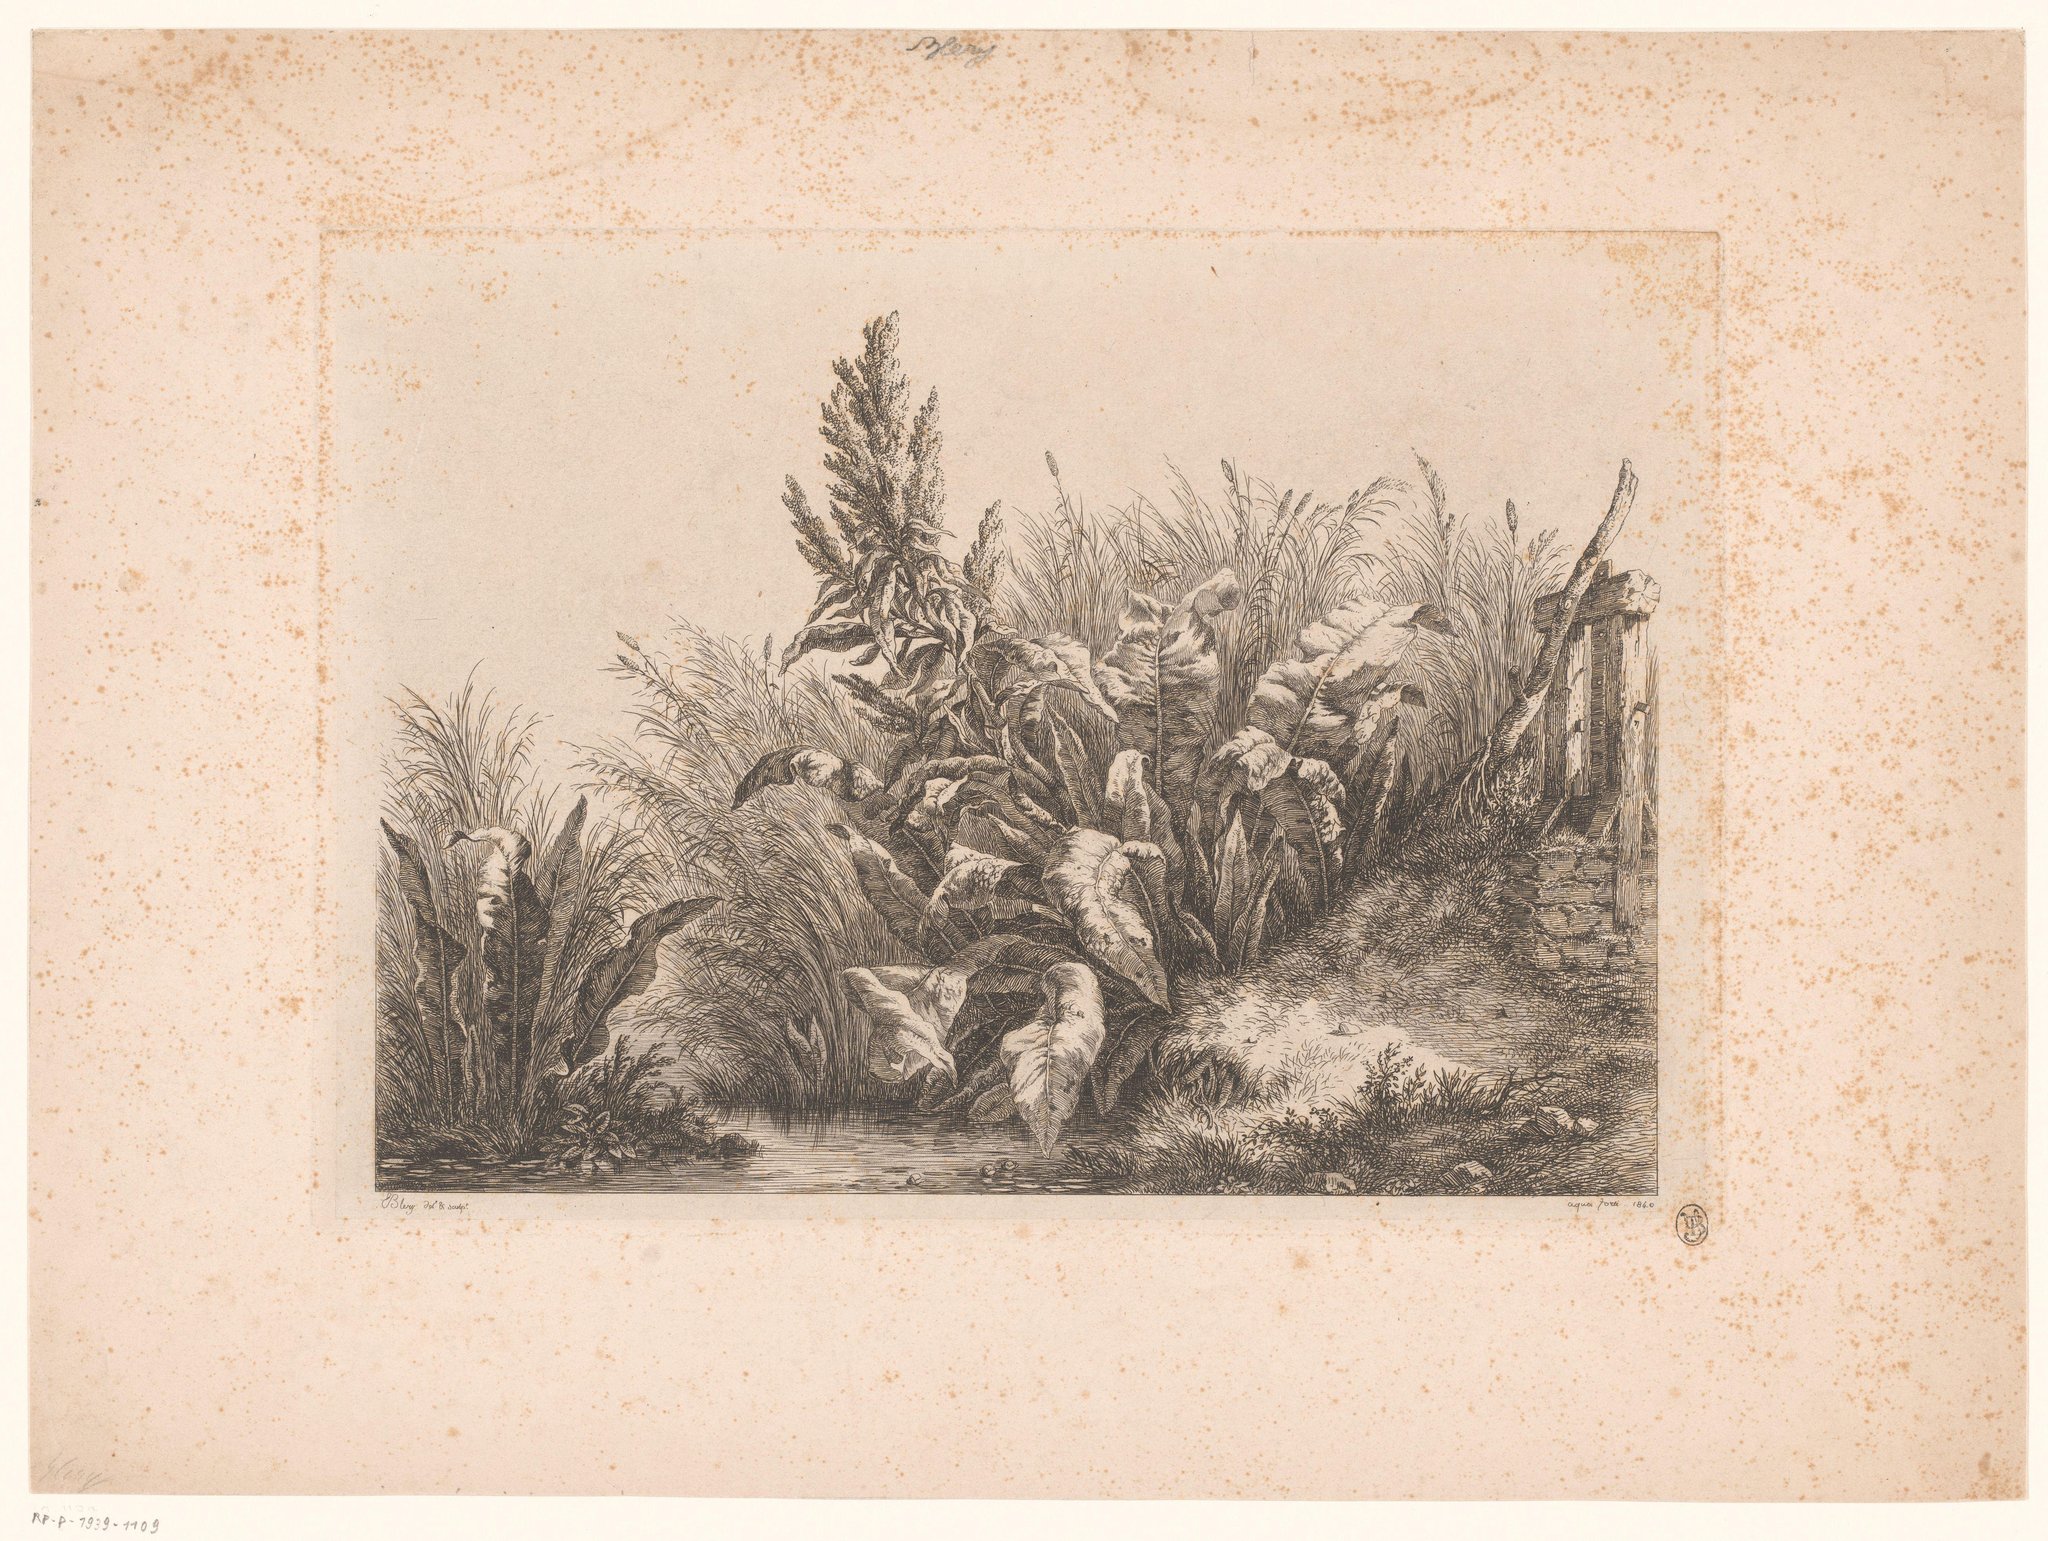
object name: print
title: Patience d'eau à la petite vanne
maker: eugène bléry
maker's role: print maker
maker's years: 1805-1887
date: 1840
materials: paper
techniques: drypoint, etching, roulette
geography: france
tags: plants (in general)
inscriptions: collector's mark: Lugt 421, collector's mark: Lugt 2166, collector's mark: Lugt 2760